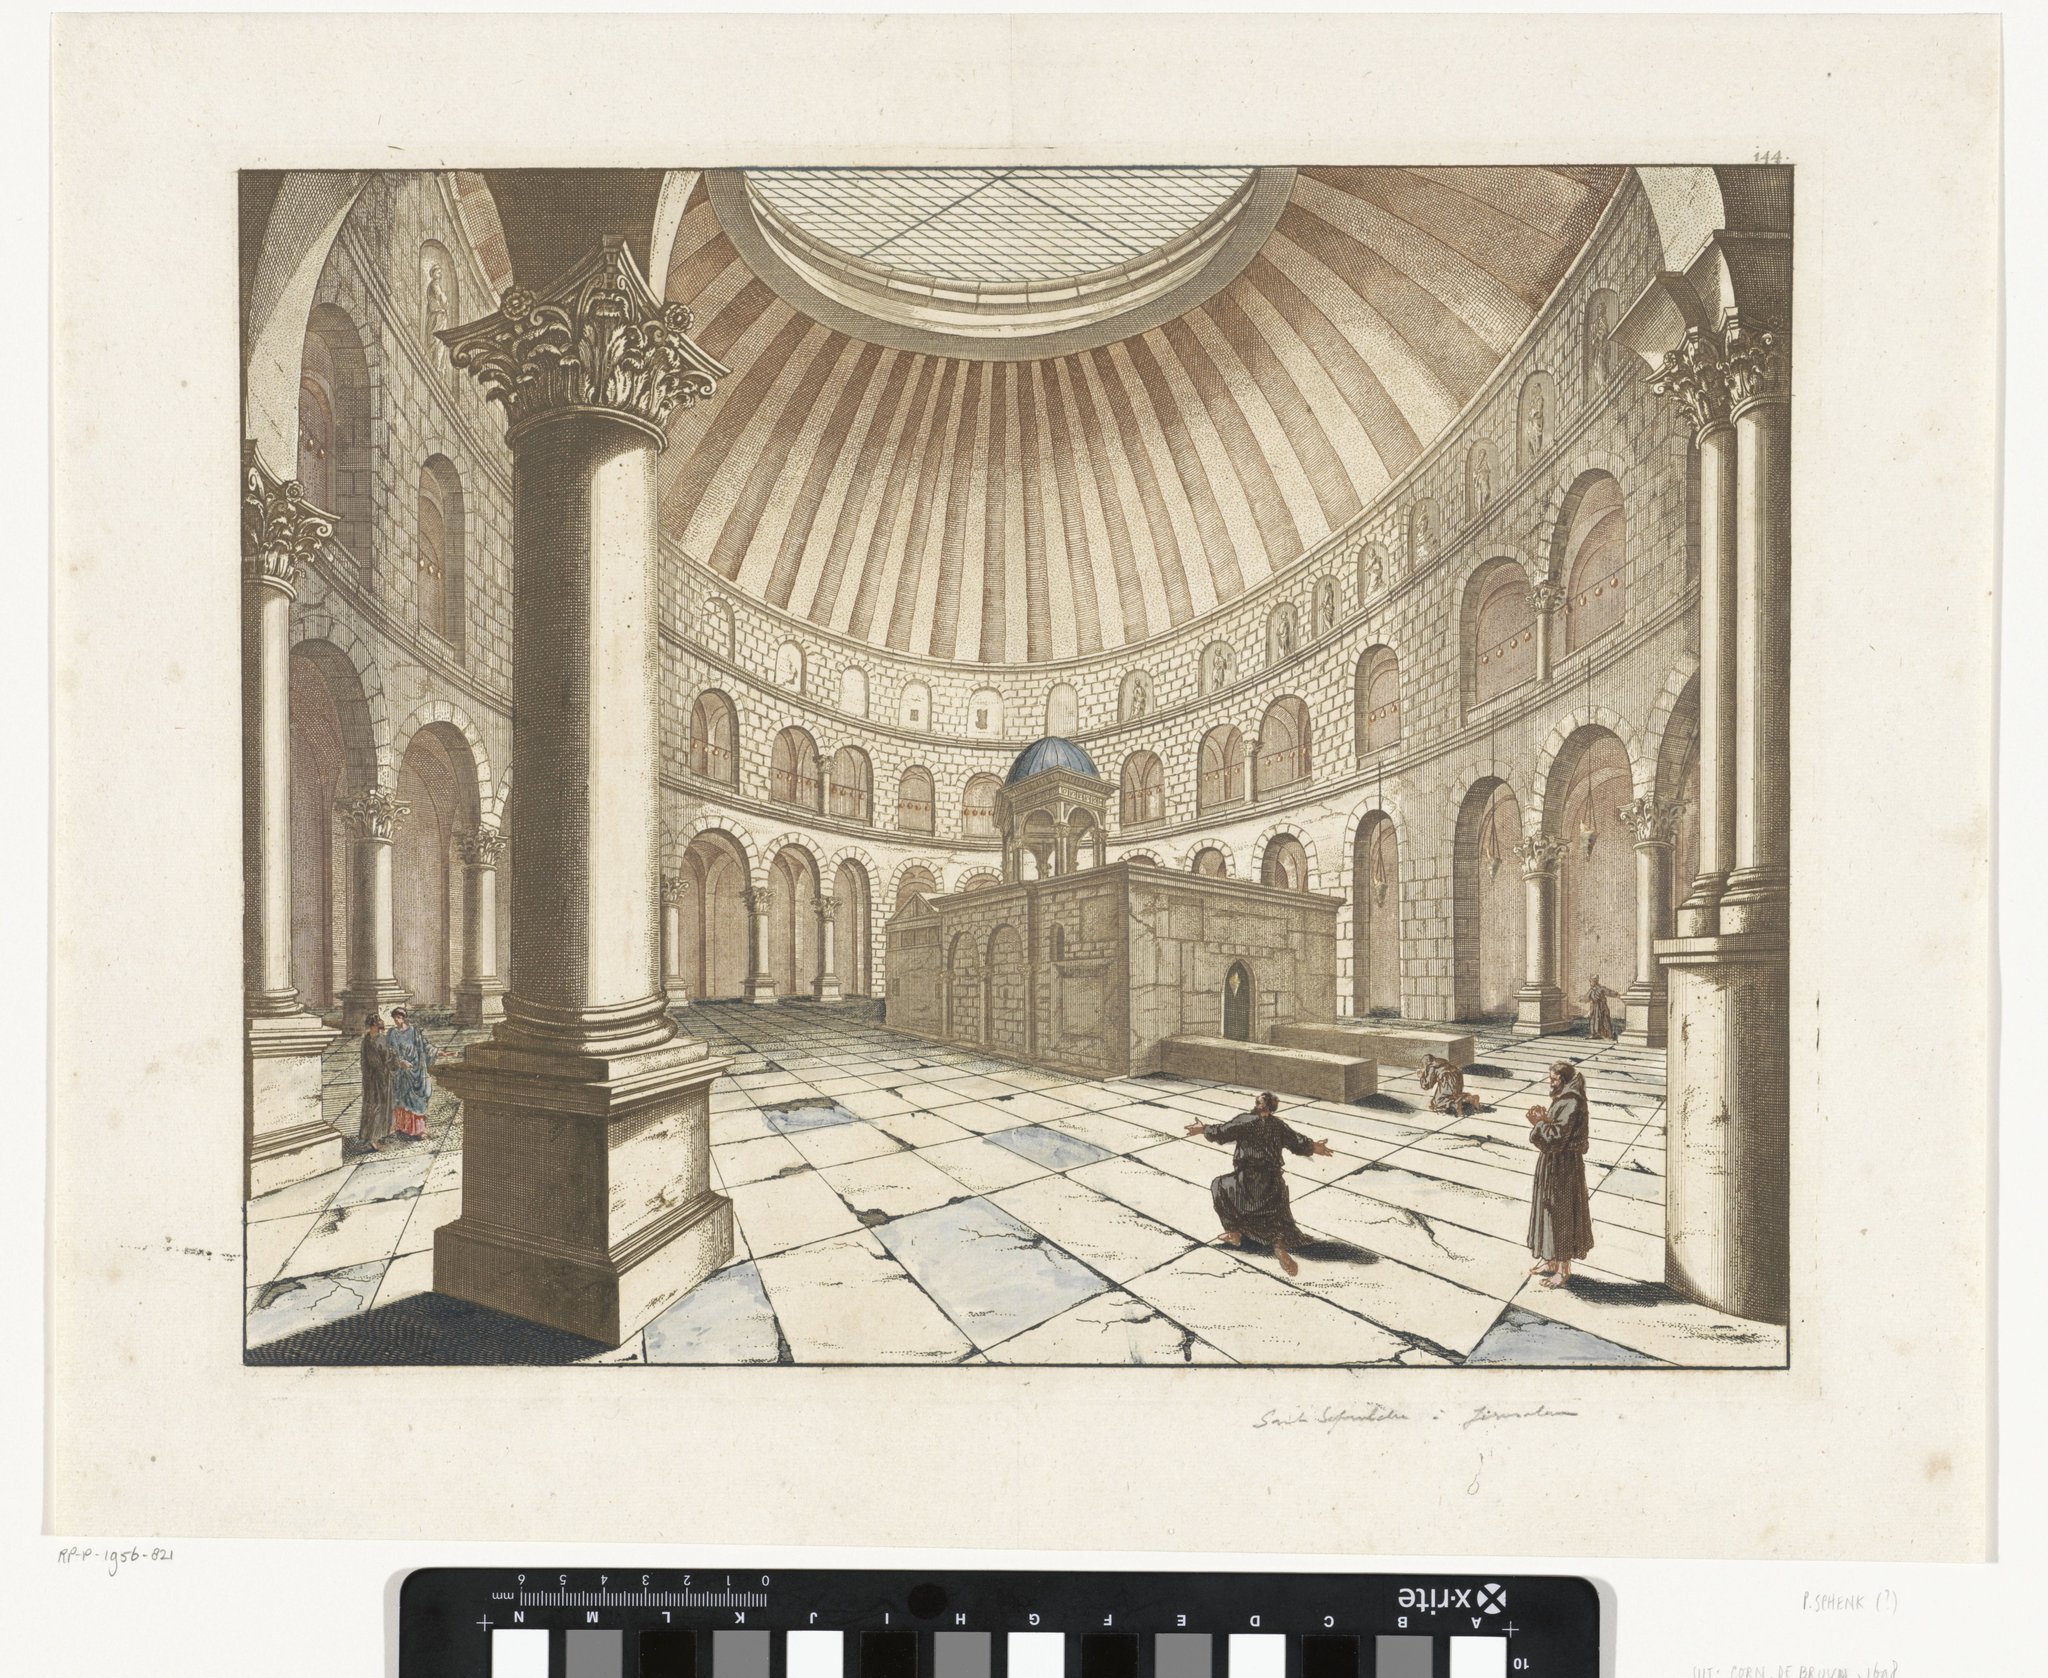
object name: print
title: Heilig Grafkerk te Jeruzalem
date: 1698-1700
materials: paper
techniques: etching, hand coloring, lithography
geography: delft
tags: interior of church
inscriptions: collector's mark: Lugt 2760, collector's mark: Lugt 2228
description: Illustratie voor: Bruyn, Cornelis de. Reizen van Cornelis de Bruyn, door de vermaardste deelen van Klein Asia. Delft: Hendrik van Kroonevelt, 1698. De Nederlandse editie is lang geleden uit elkaar gehaald.